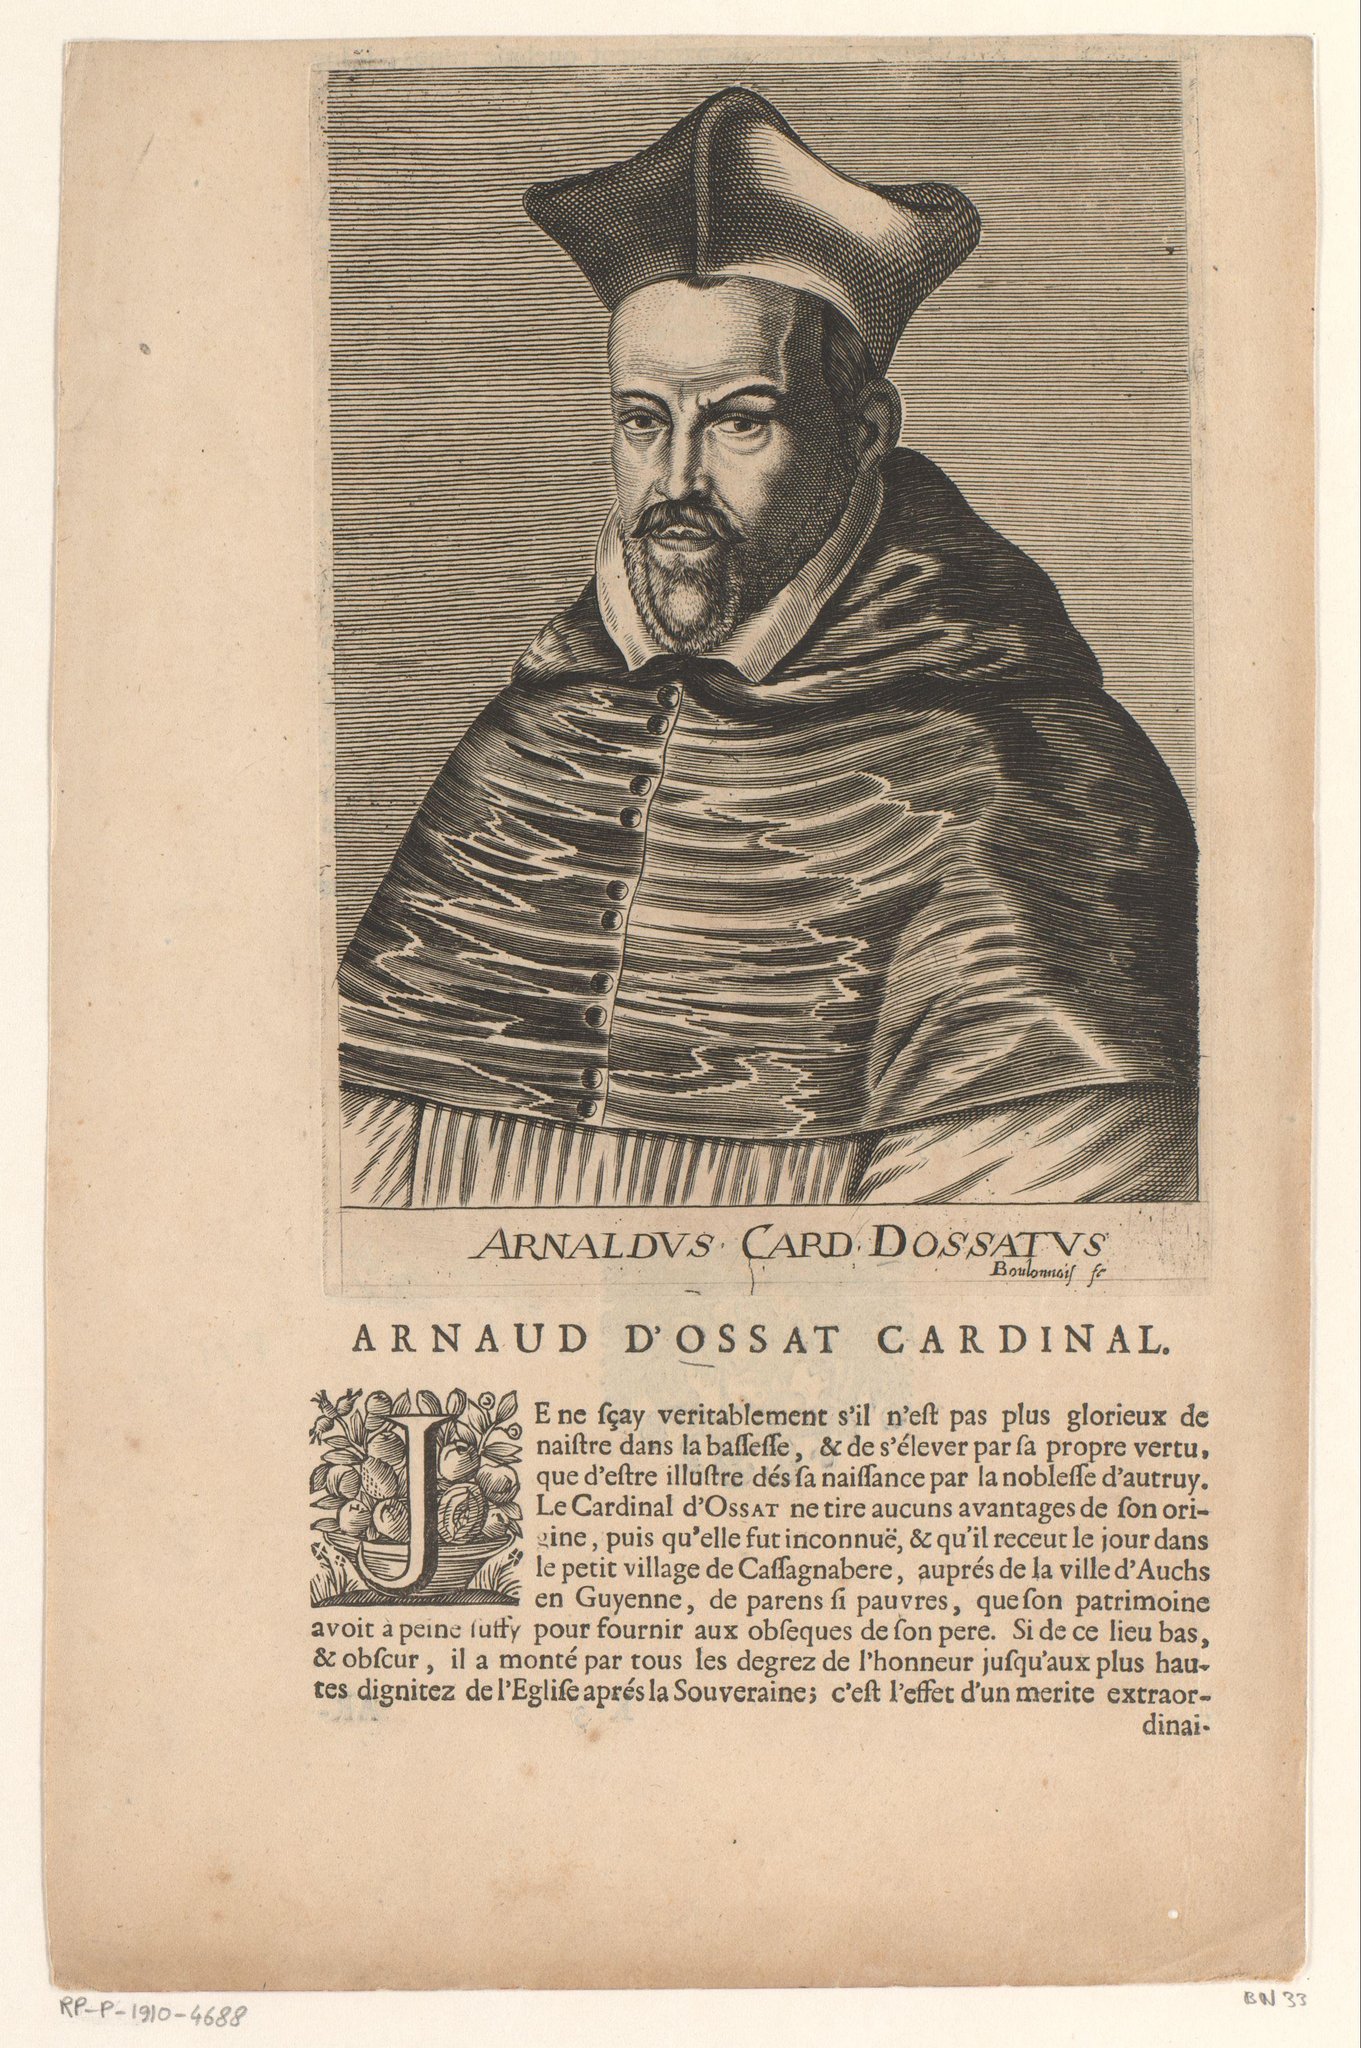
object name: print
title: Portret van Arnaud d'Ossat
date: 1682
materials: paper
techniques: engraving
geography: brussels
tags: cardinal, historical persons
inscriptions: collector's mark: Lugt 2228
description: Prent uit: Bullert, Isaac. Académie des Sciences et Arts contenant les vies et éloges his. des hommes illustres qui ont excellé en ces professions depuis environ quatre siècles. Brussel: Foppens, François, 1682. Het boek werd in 1682 eveneens in Amsterdam uitgegeven door de erfgenamen van Daniel Elzevier. Deze portretten dienen ter illustratie van de biografie van een kunstenaar of geleerde. De meeste portretten werden door Nicolas de Larmessin vervaardigd (162), 93 door De Boulonois en een derde door ongeïdentificeerde prentmakers. Dit betreft een illustratie op p. 82, deel I.